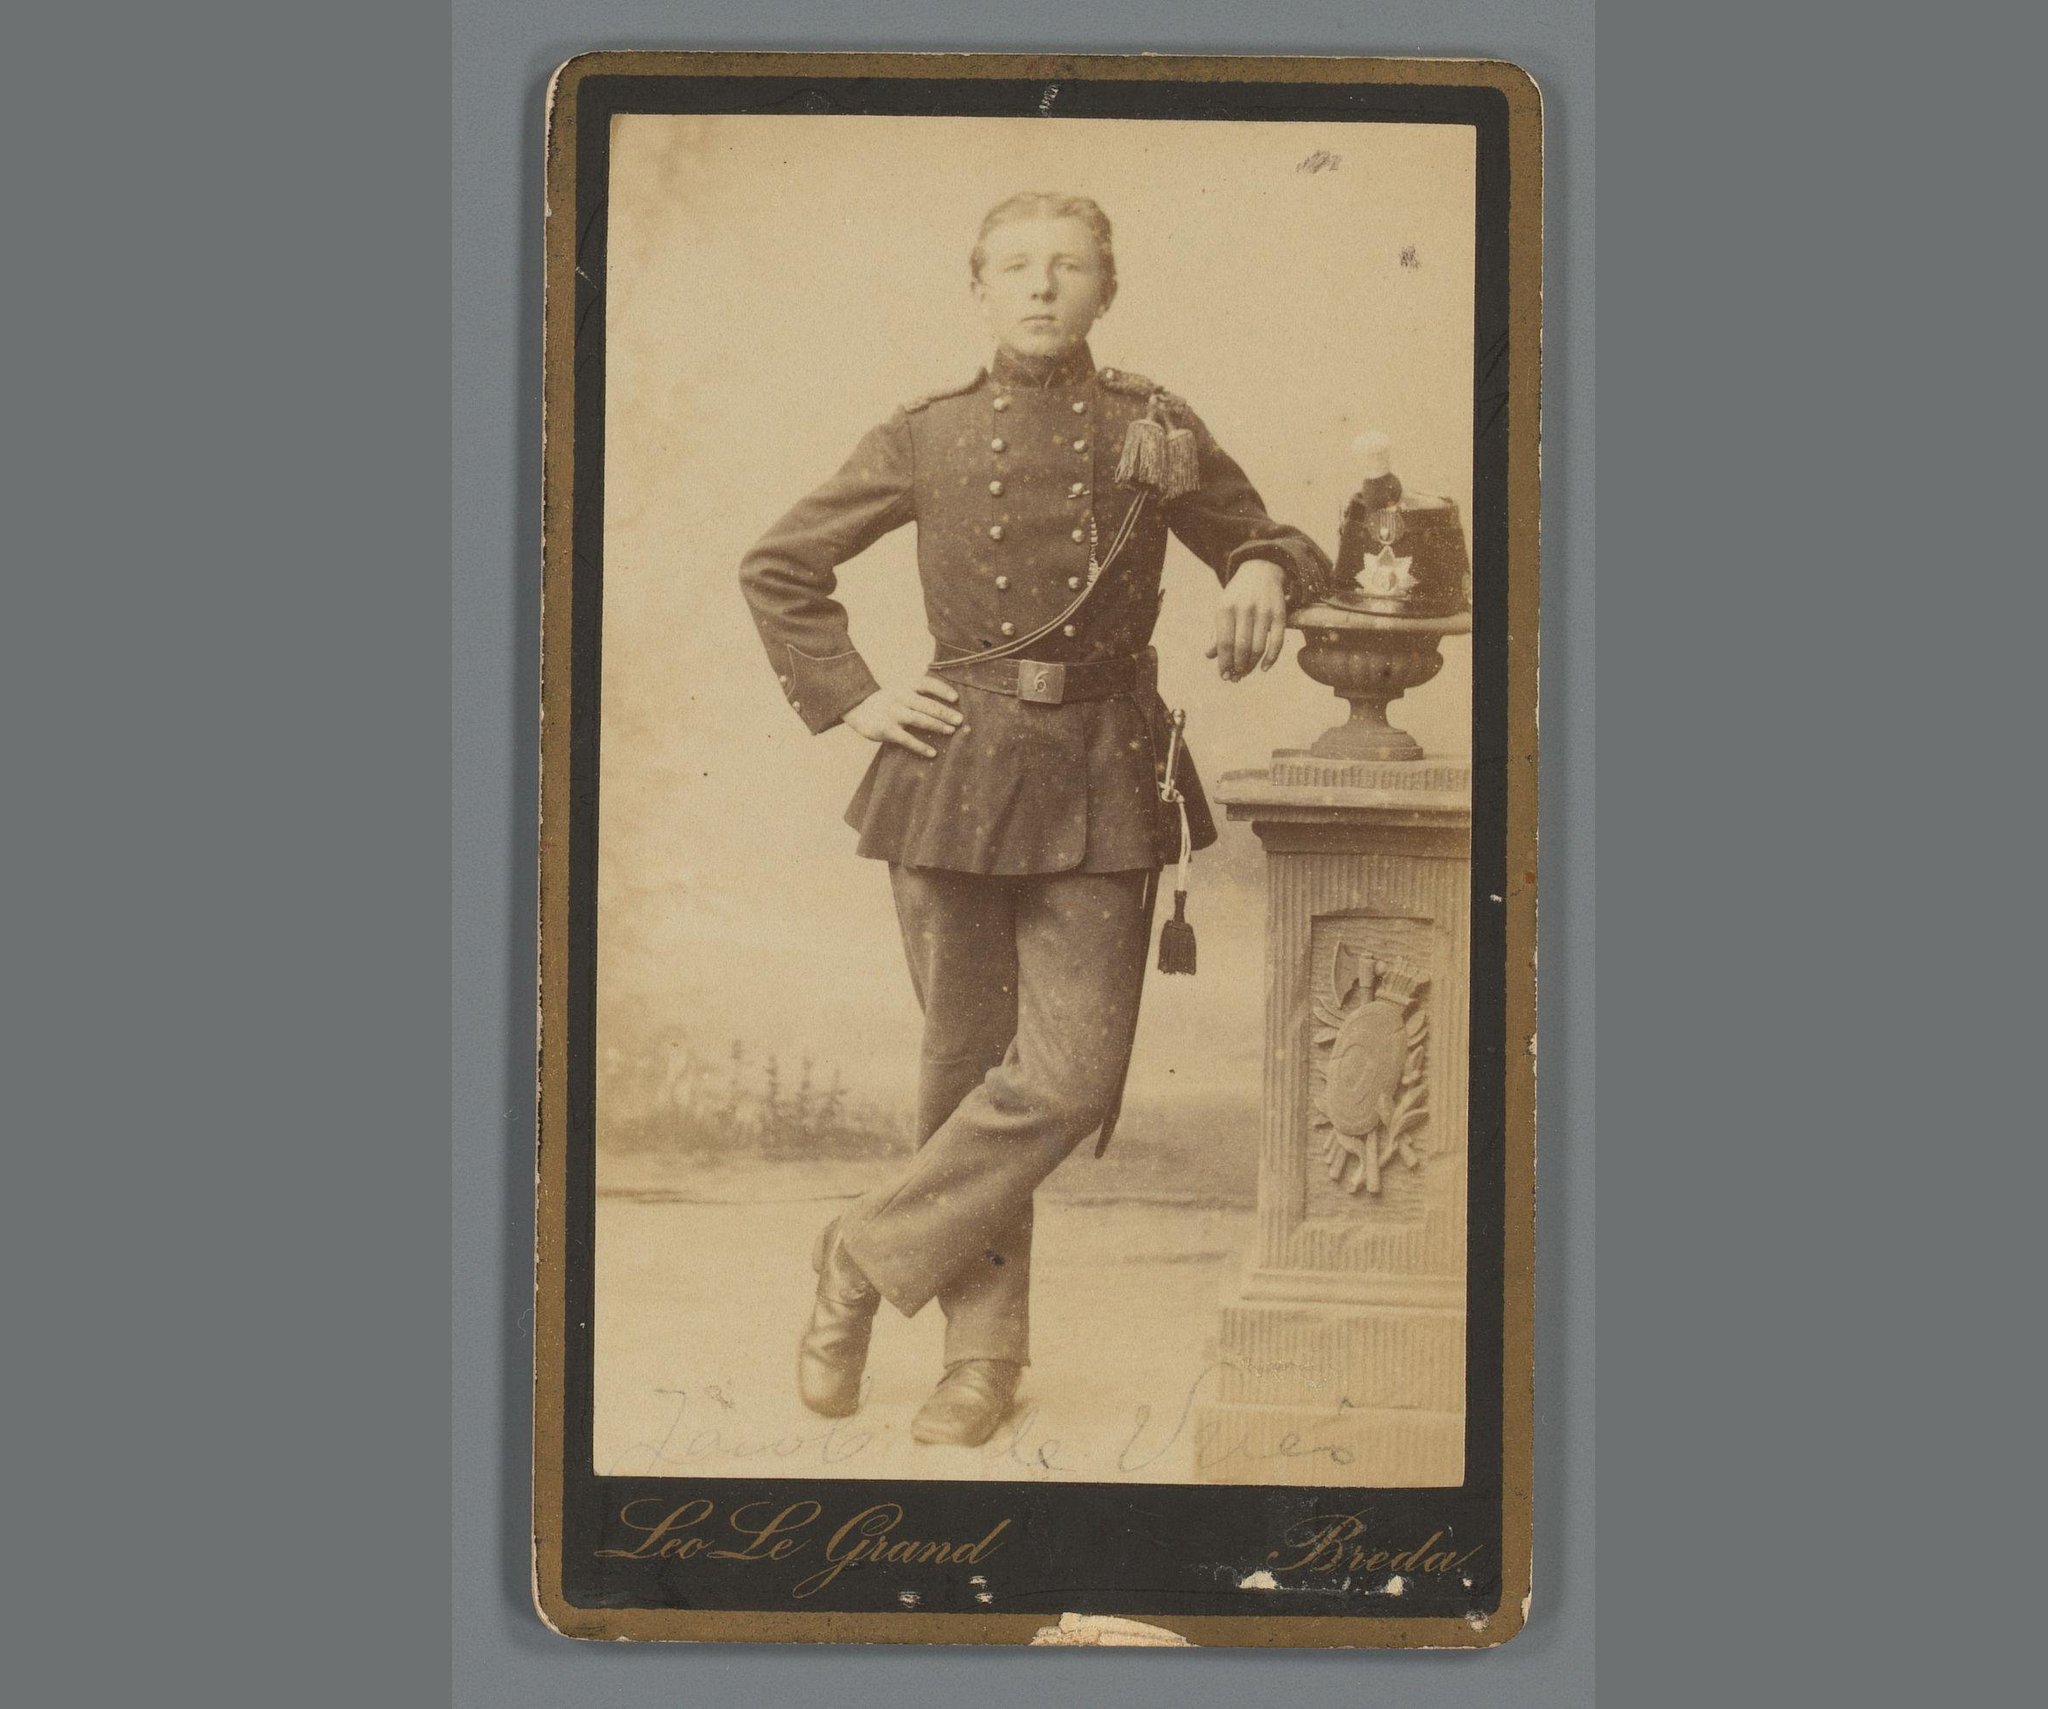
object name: carte de visite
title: Portret van een onbekende jongen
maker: le grand (fotograaf)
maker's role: fotograaf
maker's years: 1857-1942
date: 1897-1909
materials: cardboard, paper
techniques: albumen print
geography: breda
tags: historical persons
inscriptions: inscription: ‘LG/ Leo Le Grand/ PHOTOGRAPHE/ BREDA/ Visscherstraat C.313./ Gelieve bij nabestelling bovenstaand/ nummer optegeven.’